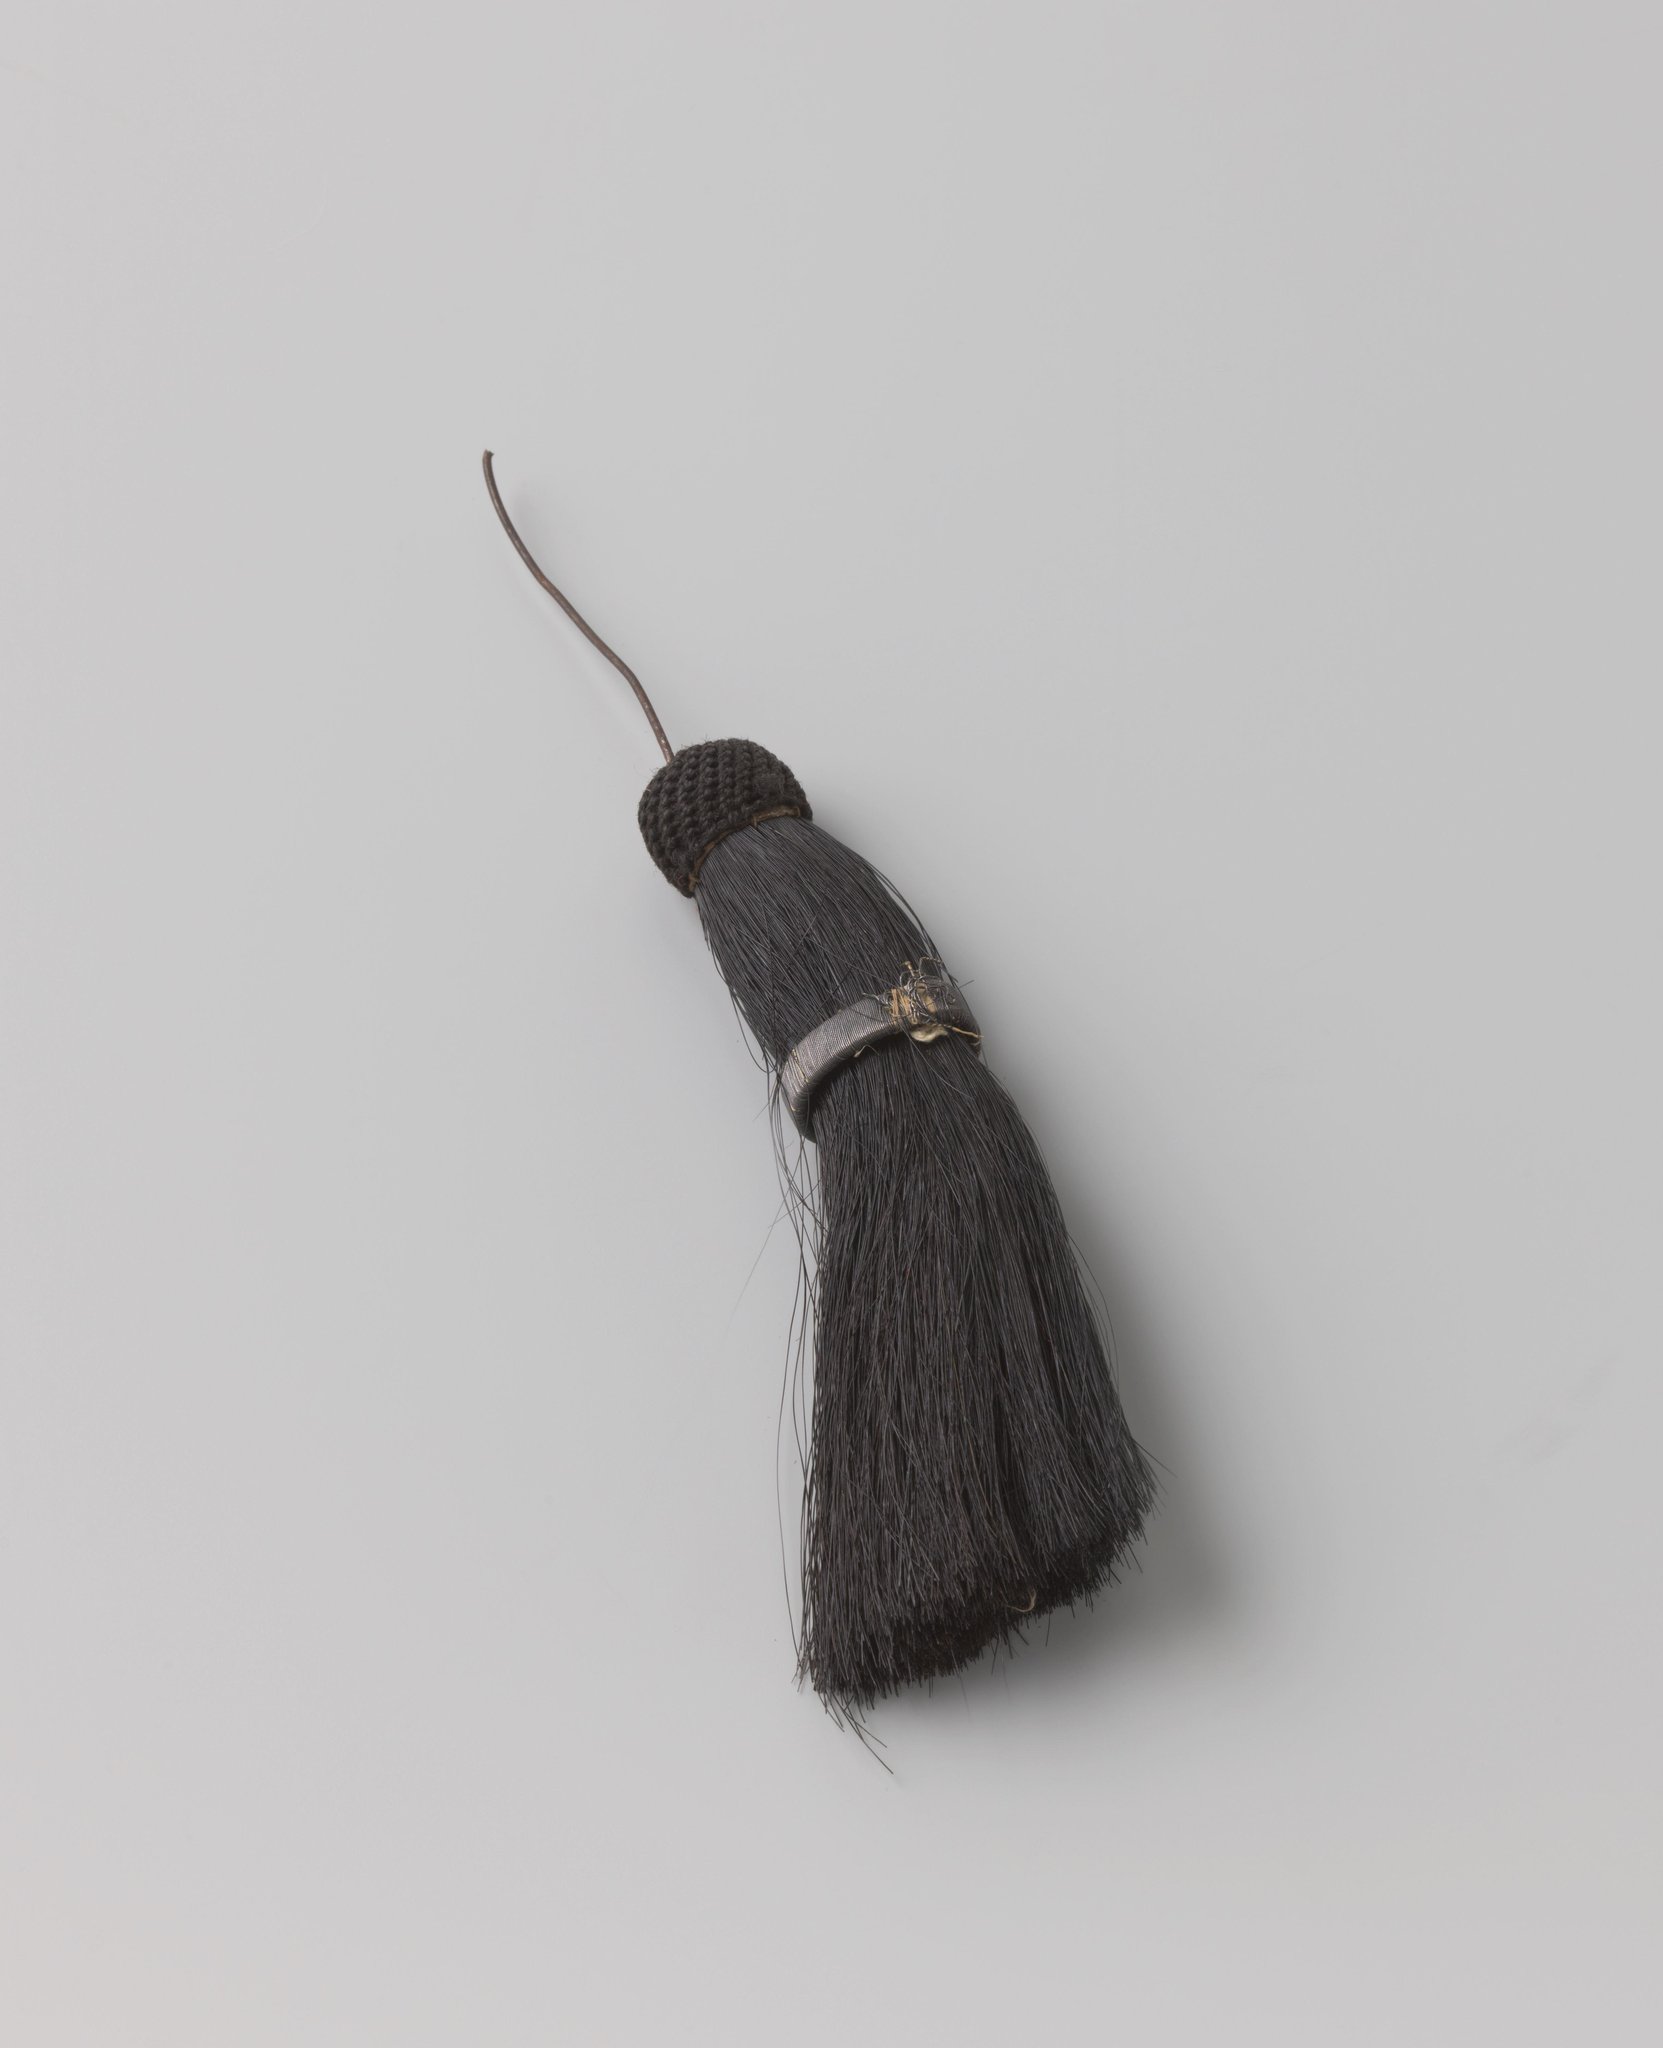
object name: plume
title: Zwarte pluim voor sjako M. 1828 voor of (1) bataljons jagers of (2) vrijwillige jagerkorpsen of (3) artillerie schutterij, voor alle rangen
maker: Anonymous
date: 1830-1839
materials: hair, metal, wool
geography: netherlands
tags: netherlands, belgium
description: Pluim van zwart paardehaar, gemonteerd op geel of wit metalen draad. Aan de kern met een netwerk van zwarte wol omgeven. Met een witmetalen ring (=artillerie-schutterij).